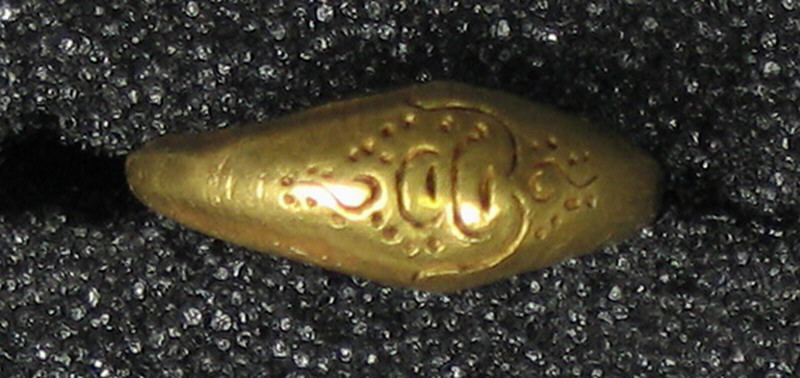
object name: ring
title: Hollow Ring, Foliate and Oval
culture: indonesian, east java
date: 1101-1400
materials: gold